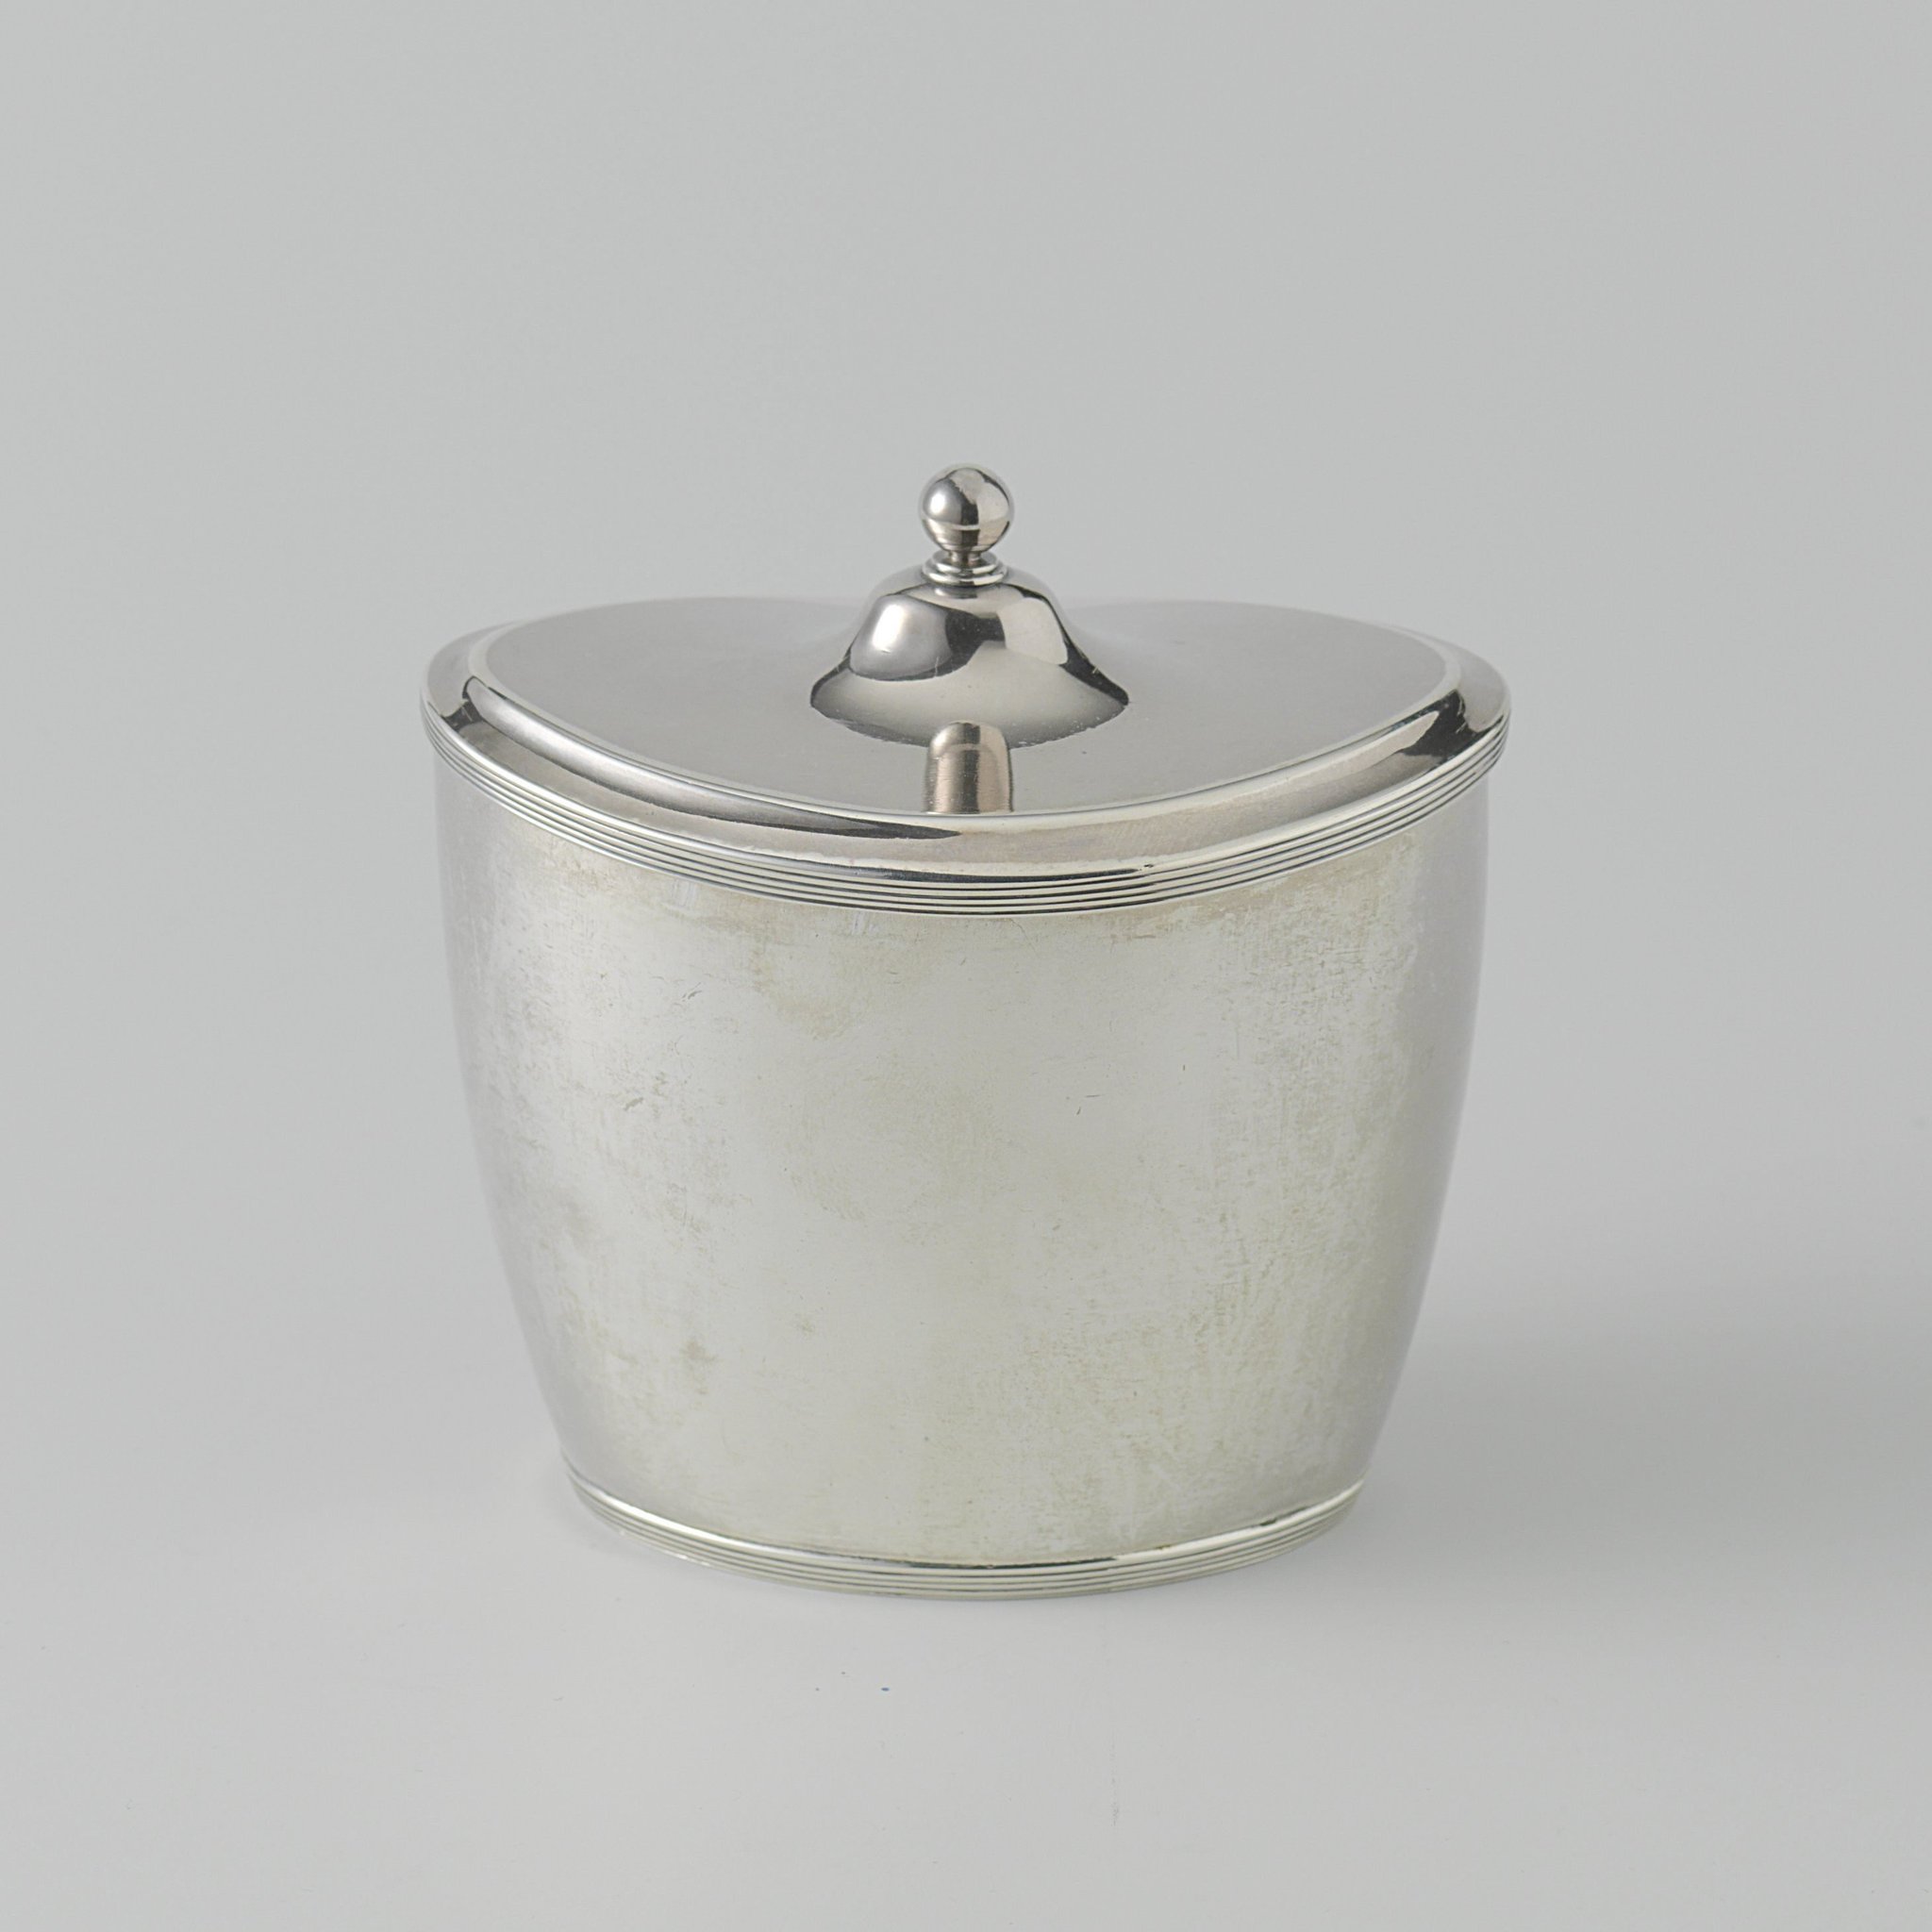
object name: tea caddy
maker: jacobus carrenhoff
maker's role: silversmith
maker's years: 1771-1848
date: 1805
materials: silver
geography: amsterdam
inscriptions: date letter: ‘W’, retailer's mark: ‘DIEMONT’, town mark, maker's mark, alloy mark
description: De ovale bus heeft een licht gewelfd, zich verbredend lichaam, dat aan de zijkanten iets hoger oploopt. Over de bus sluit een scharnierend, gewelfd deksel met een geknikte wand en een rechte onderrand. Het wordt bekroond door een ronde knop op een geprofileerd voetje. Langs de onderzijde van de bus en langs de onderrand van het deksel lopen filetranden. (Catalogus Amsterdams Goud en Zilver, catalogusnummer 159)